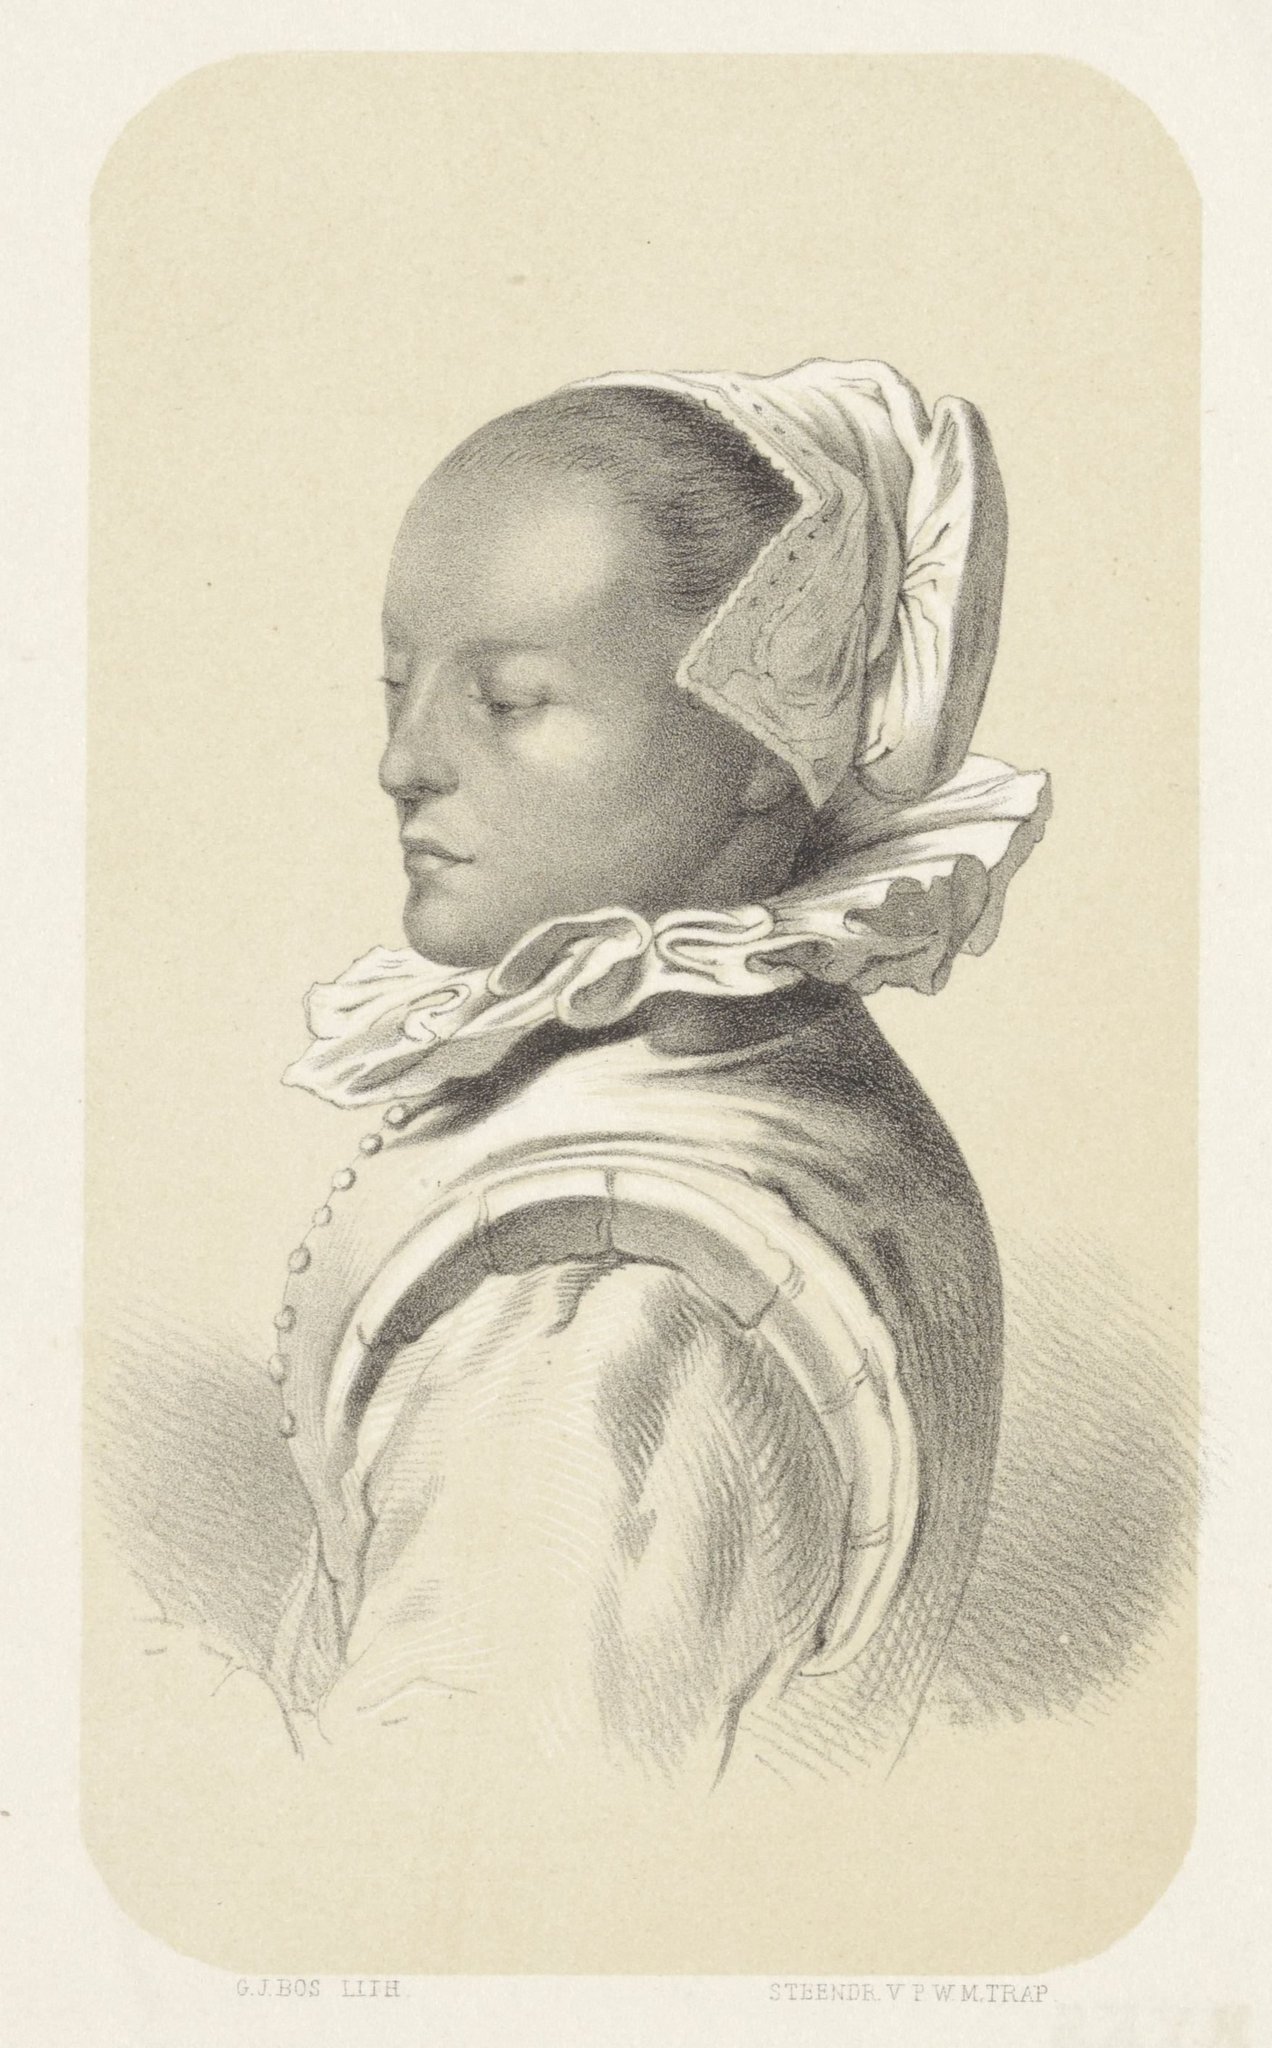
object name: print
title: Vrouw met wit kapje en kraag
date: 1835-1898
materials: paper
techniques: tone lithography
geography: leiden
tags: head-gear: cap, adolescent, young woman, maiden (+ sideview, profile), neck-gear: collar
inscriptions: collector's mark: Lugt 2165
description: De vrouw kijkt naar links en is bijna en profil weergegeven. Zij draagt een kostuum met een rij knoopjes.